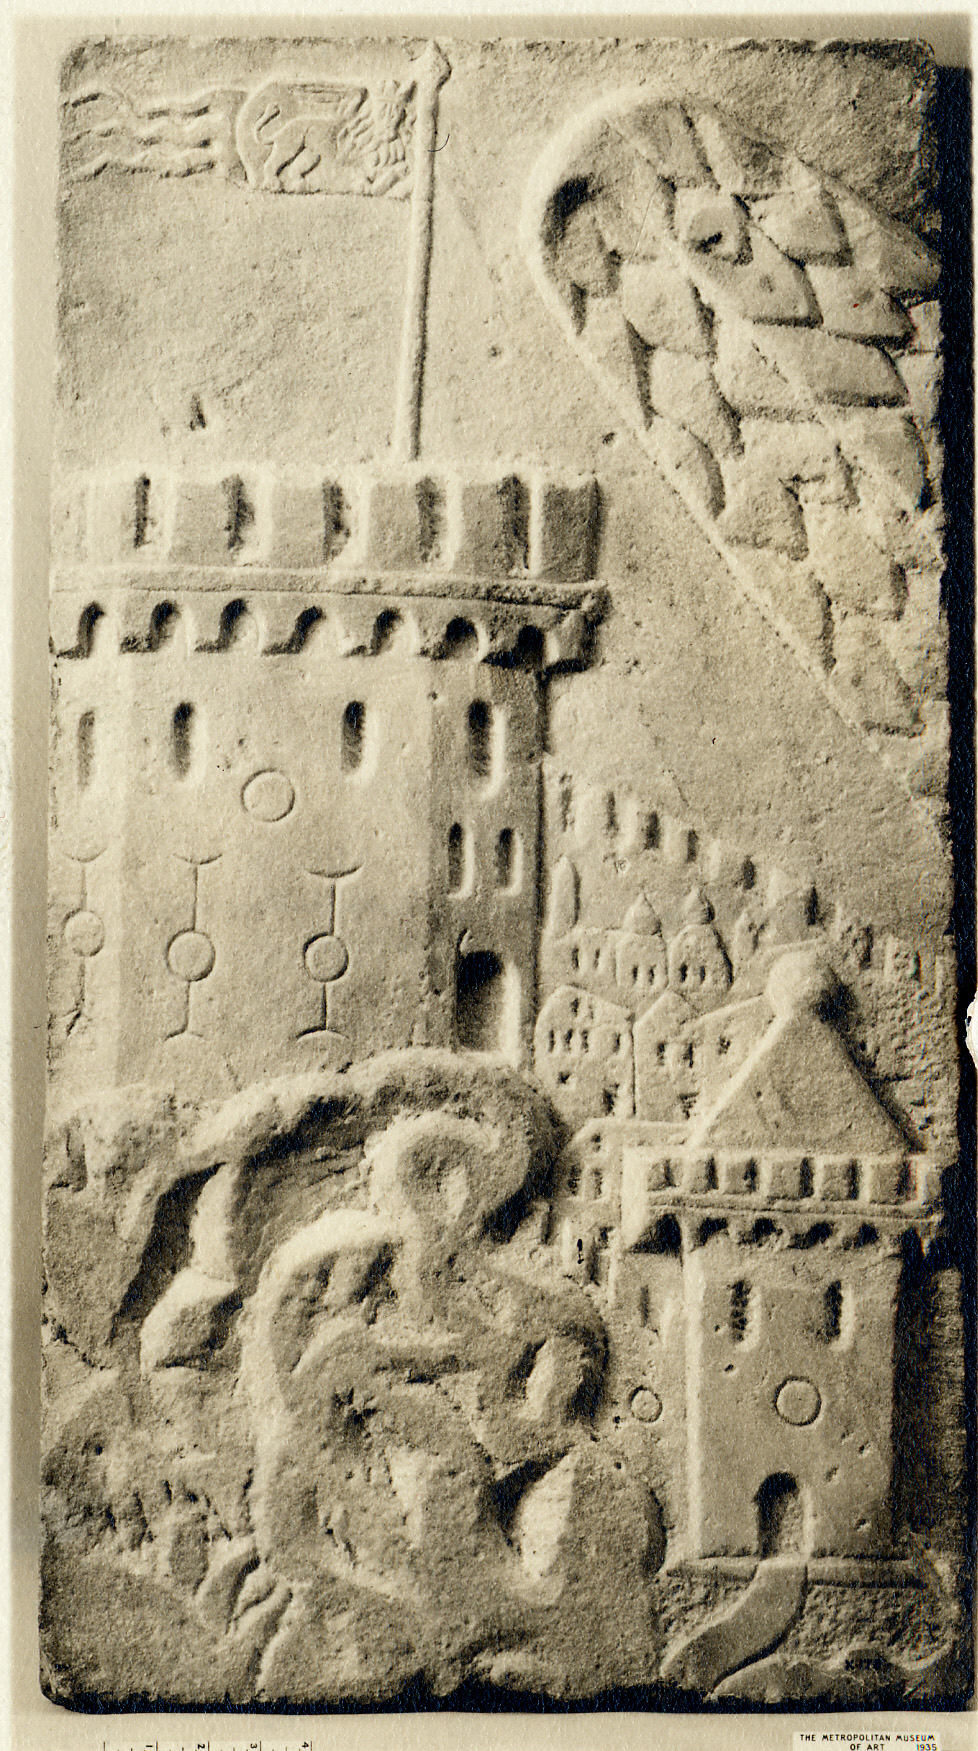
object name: fragment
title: Relief Fragment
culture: european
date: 1401-1500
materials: marble